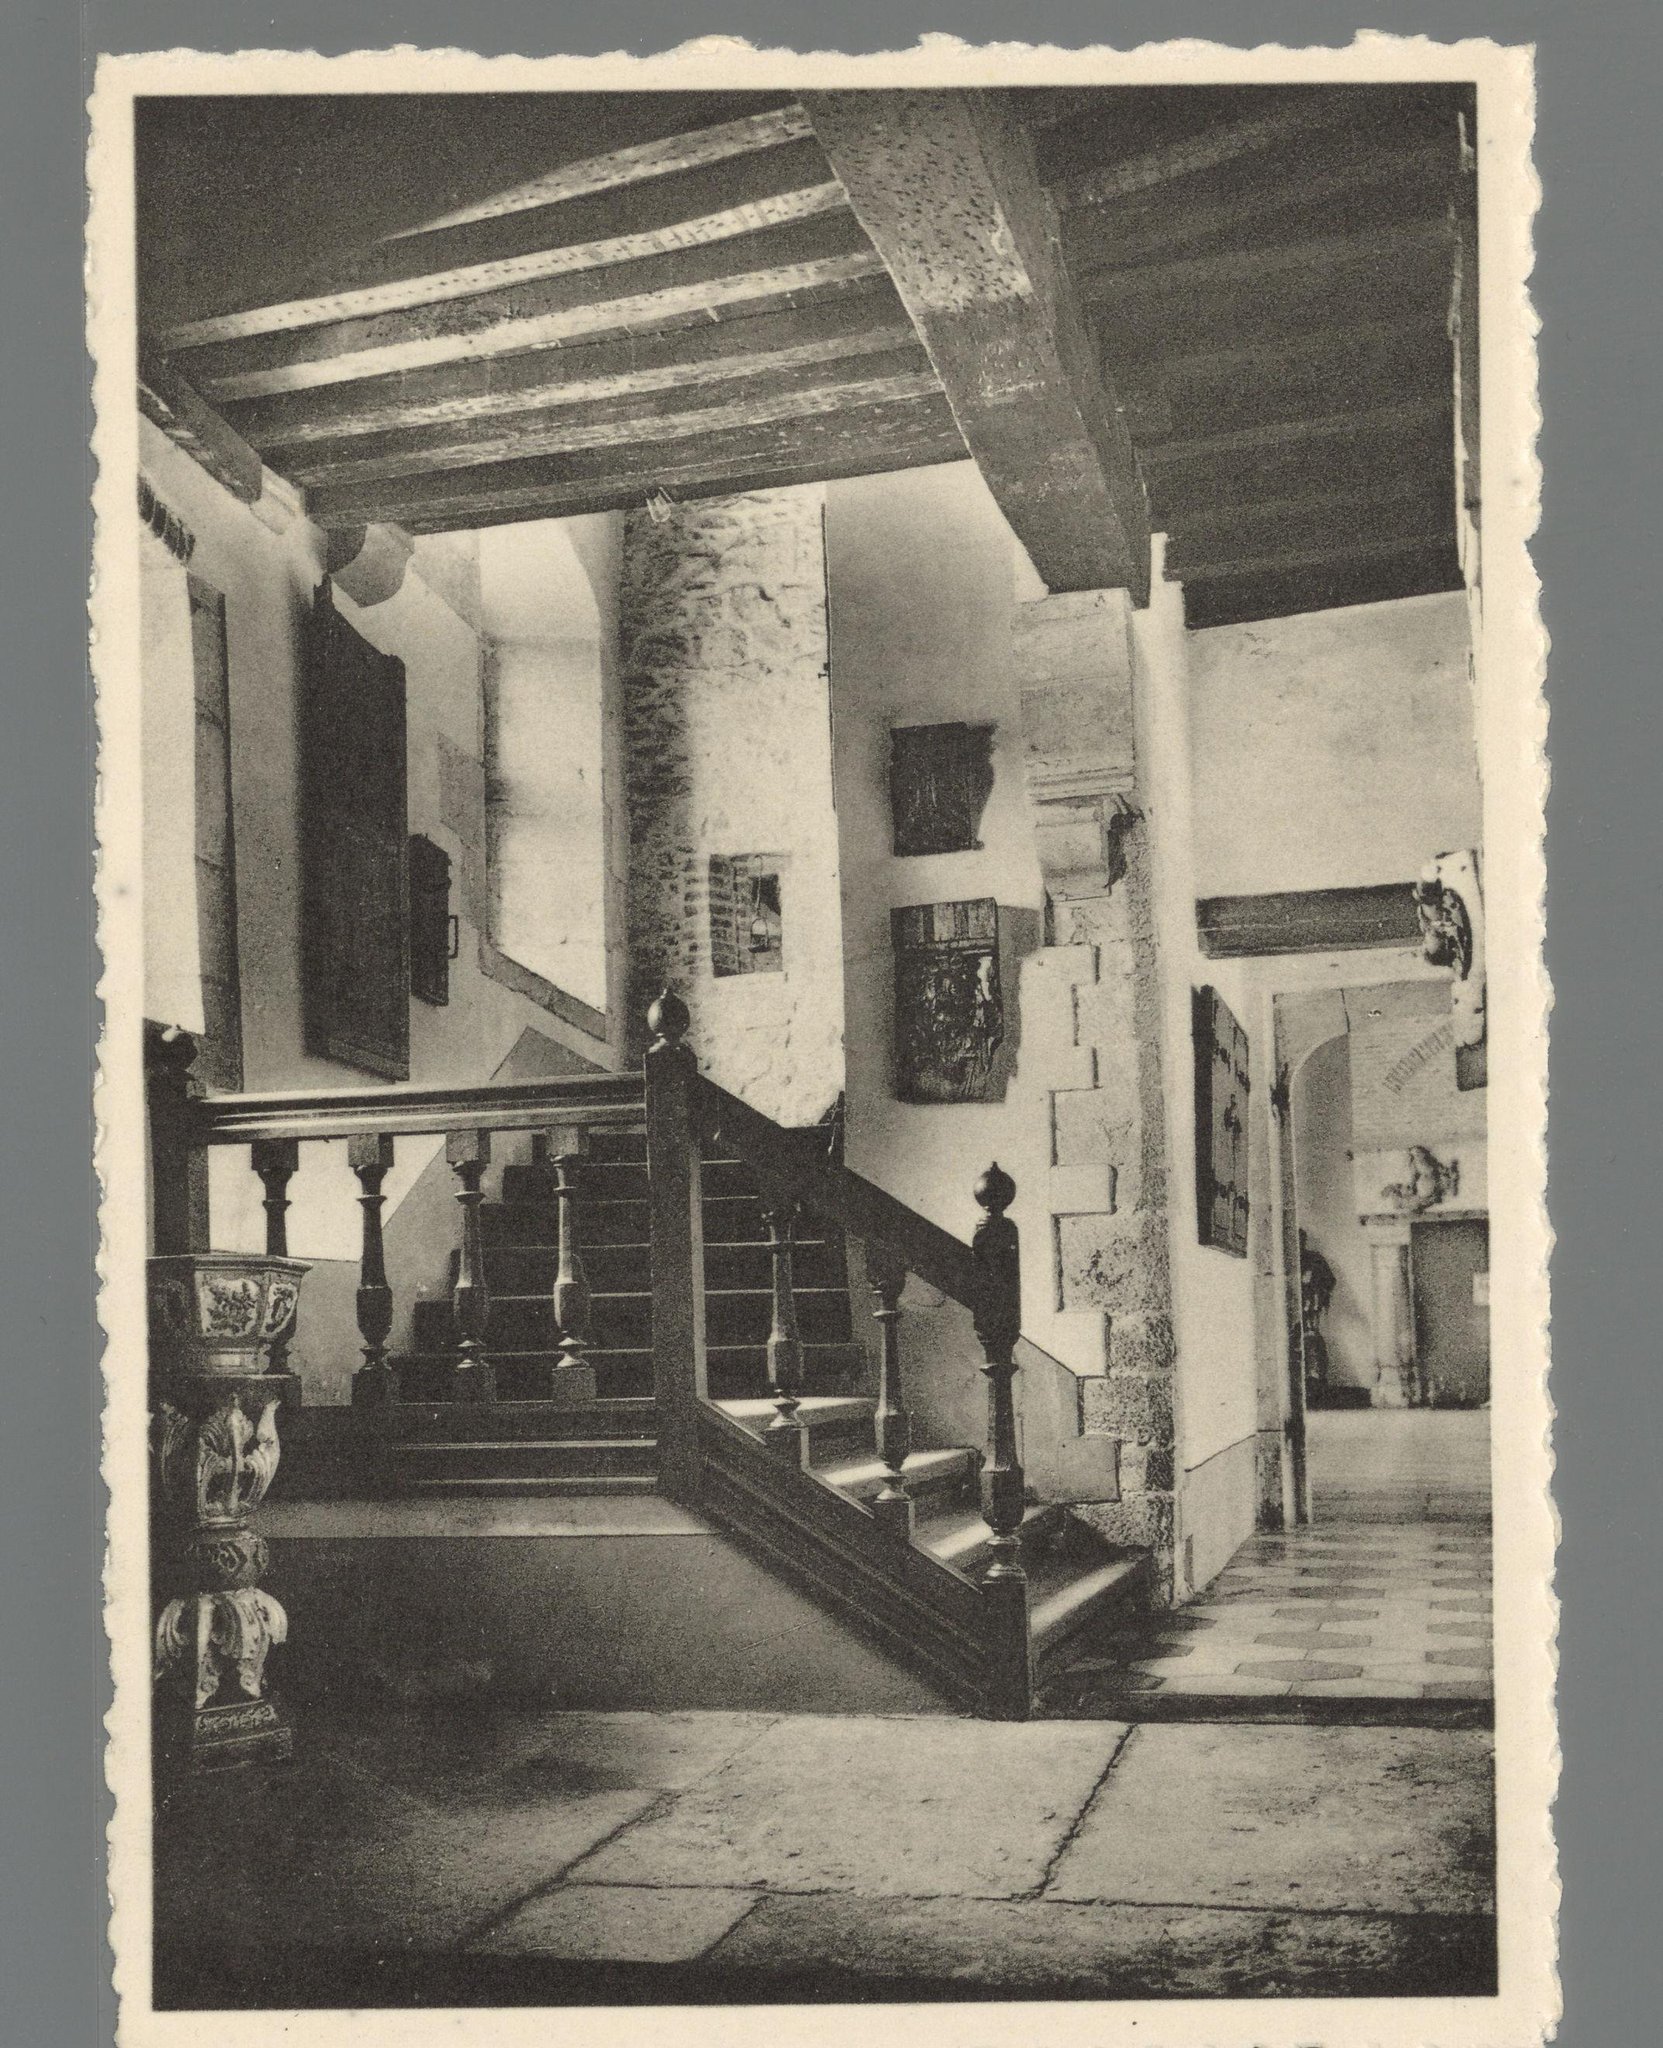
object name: photomechanical print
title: Escalier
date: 1913-1950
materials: cardboard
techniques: photograph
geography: brussels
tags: castle, permanent exhibition, museum, interior ~ representation of a building